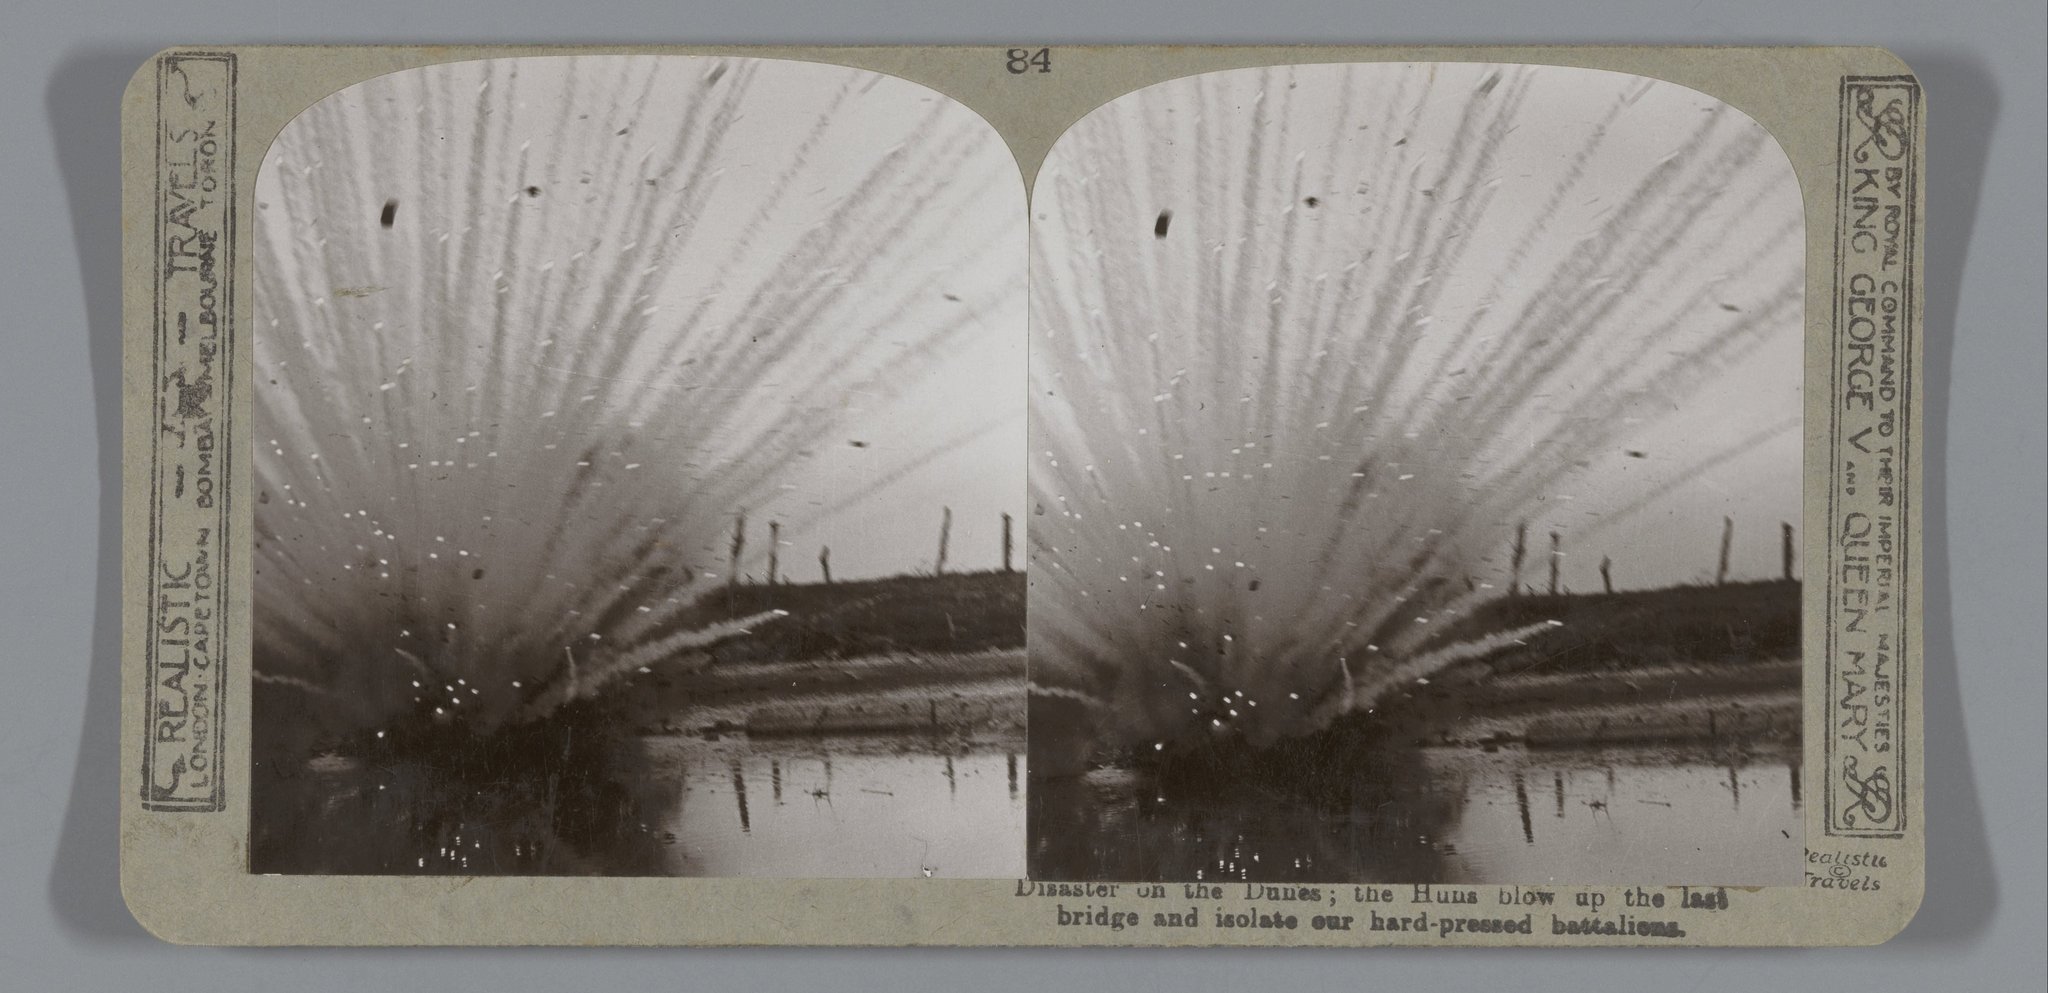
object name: stereograph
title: Disaster on the Dunes the Huns blow up the last bridge and isolate our hard-pressed battalions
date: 1914-1918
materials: cardboard, photographic support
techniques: gelatin silver print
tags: projectiles, explosives, etc.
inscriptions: inscription: ‘By Royal command to their Imperial majesties King George V and Queen Mary’, number: ‘84’